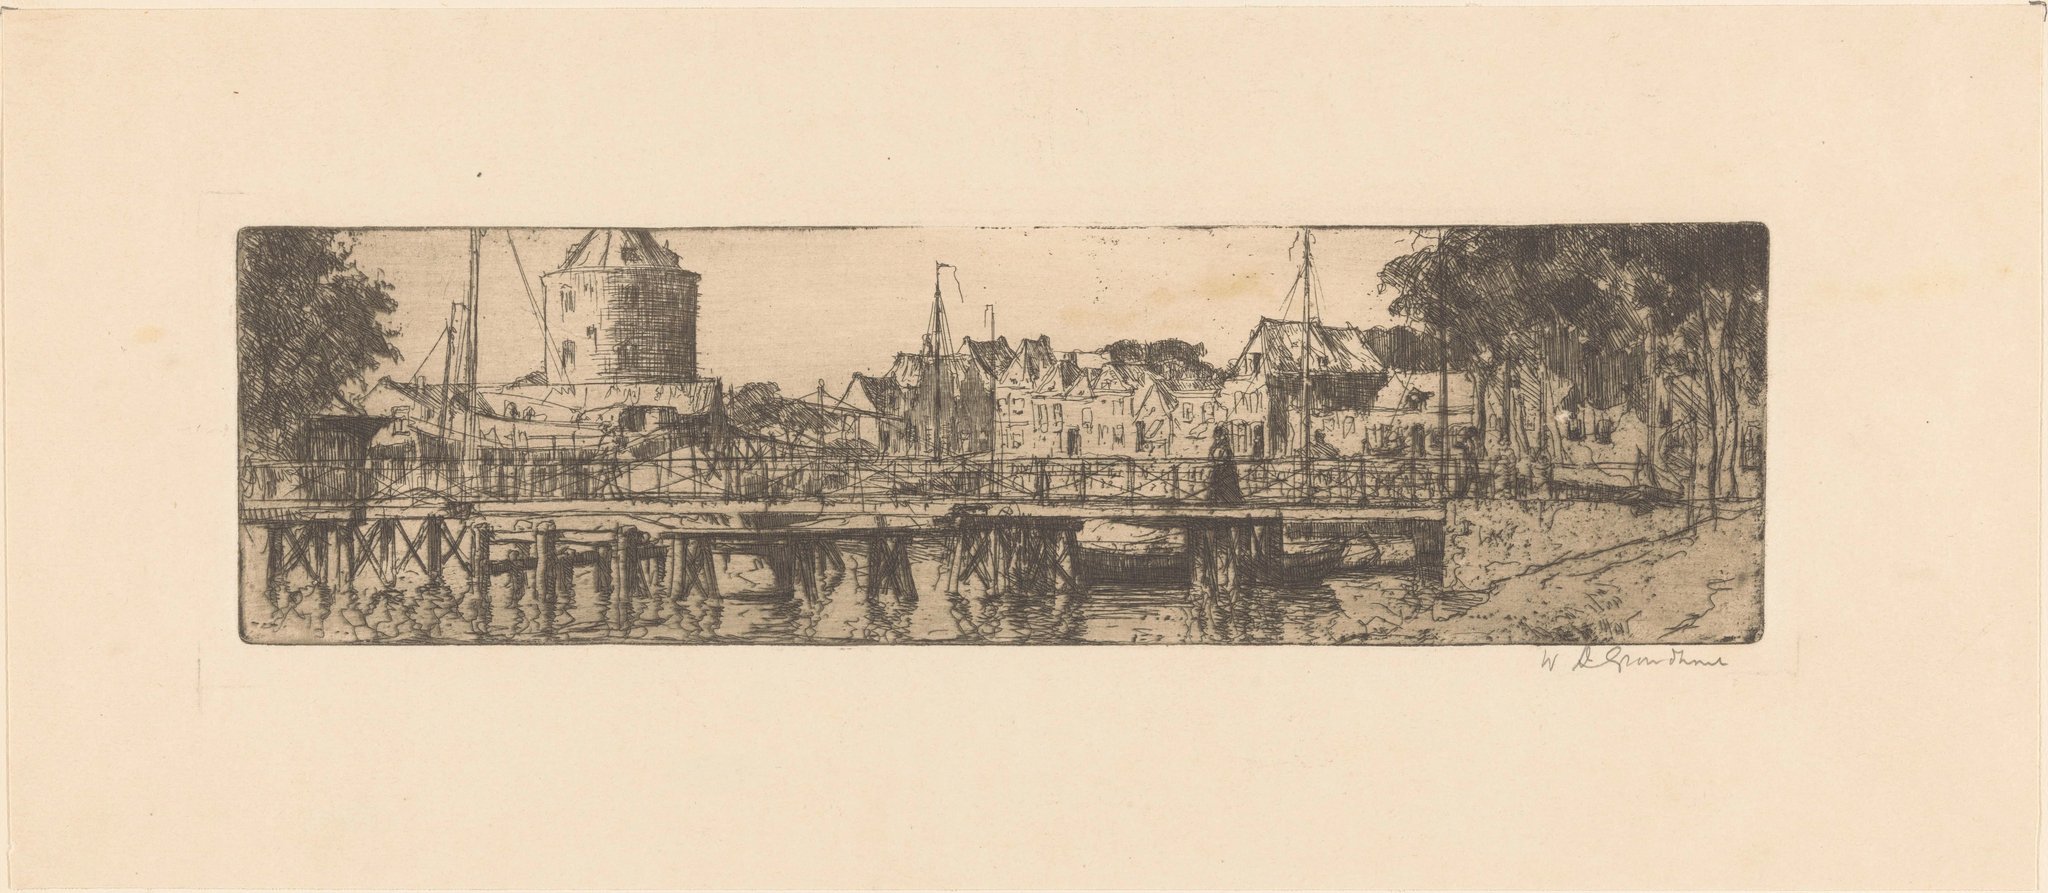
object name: print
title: Enkhuizen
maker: willem adrianus grondhout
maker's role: draughtsman, painter, print maker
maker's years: 1878-1934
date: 1888-1934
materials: paper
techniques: etching, intaglio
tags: harbour, canals, waters (in city), enkhuizen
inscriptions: collector's mark: Lugt 2228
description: De haven van Enkhuizen met een steiger en afgemeerde schepen. Links op de achtergrond de Drommedaris, de zuidelijke toegangspoort van de stad.